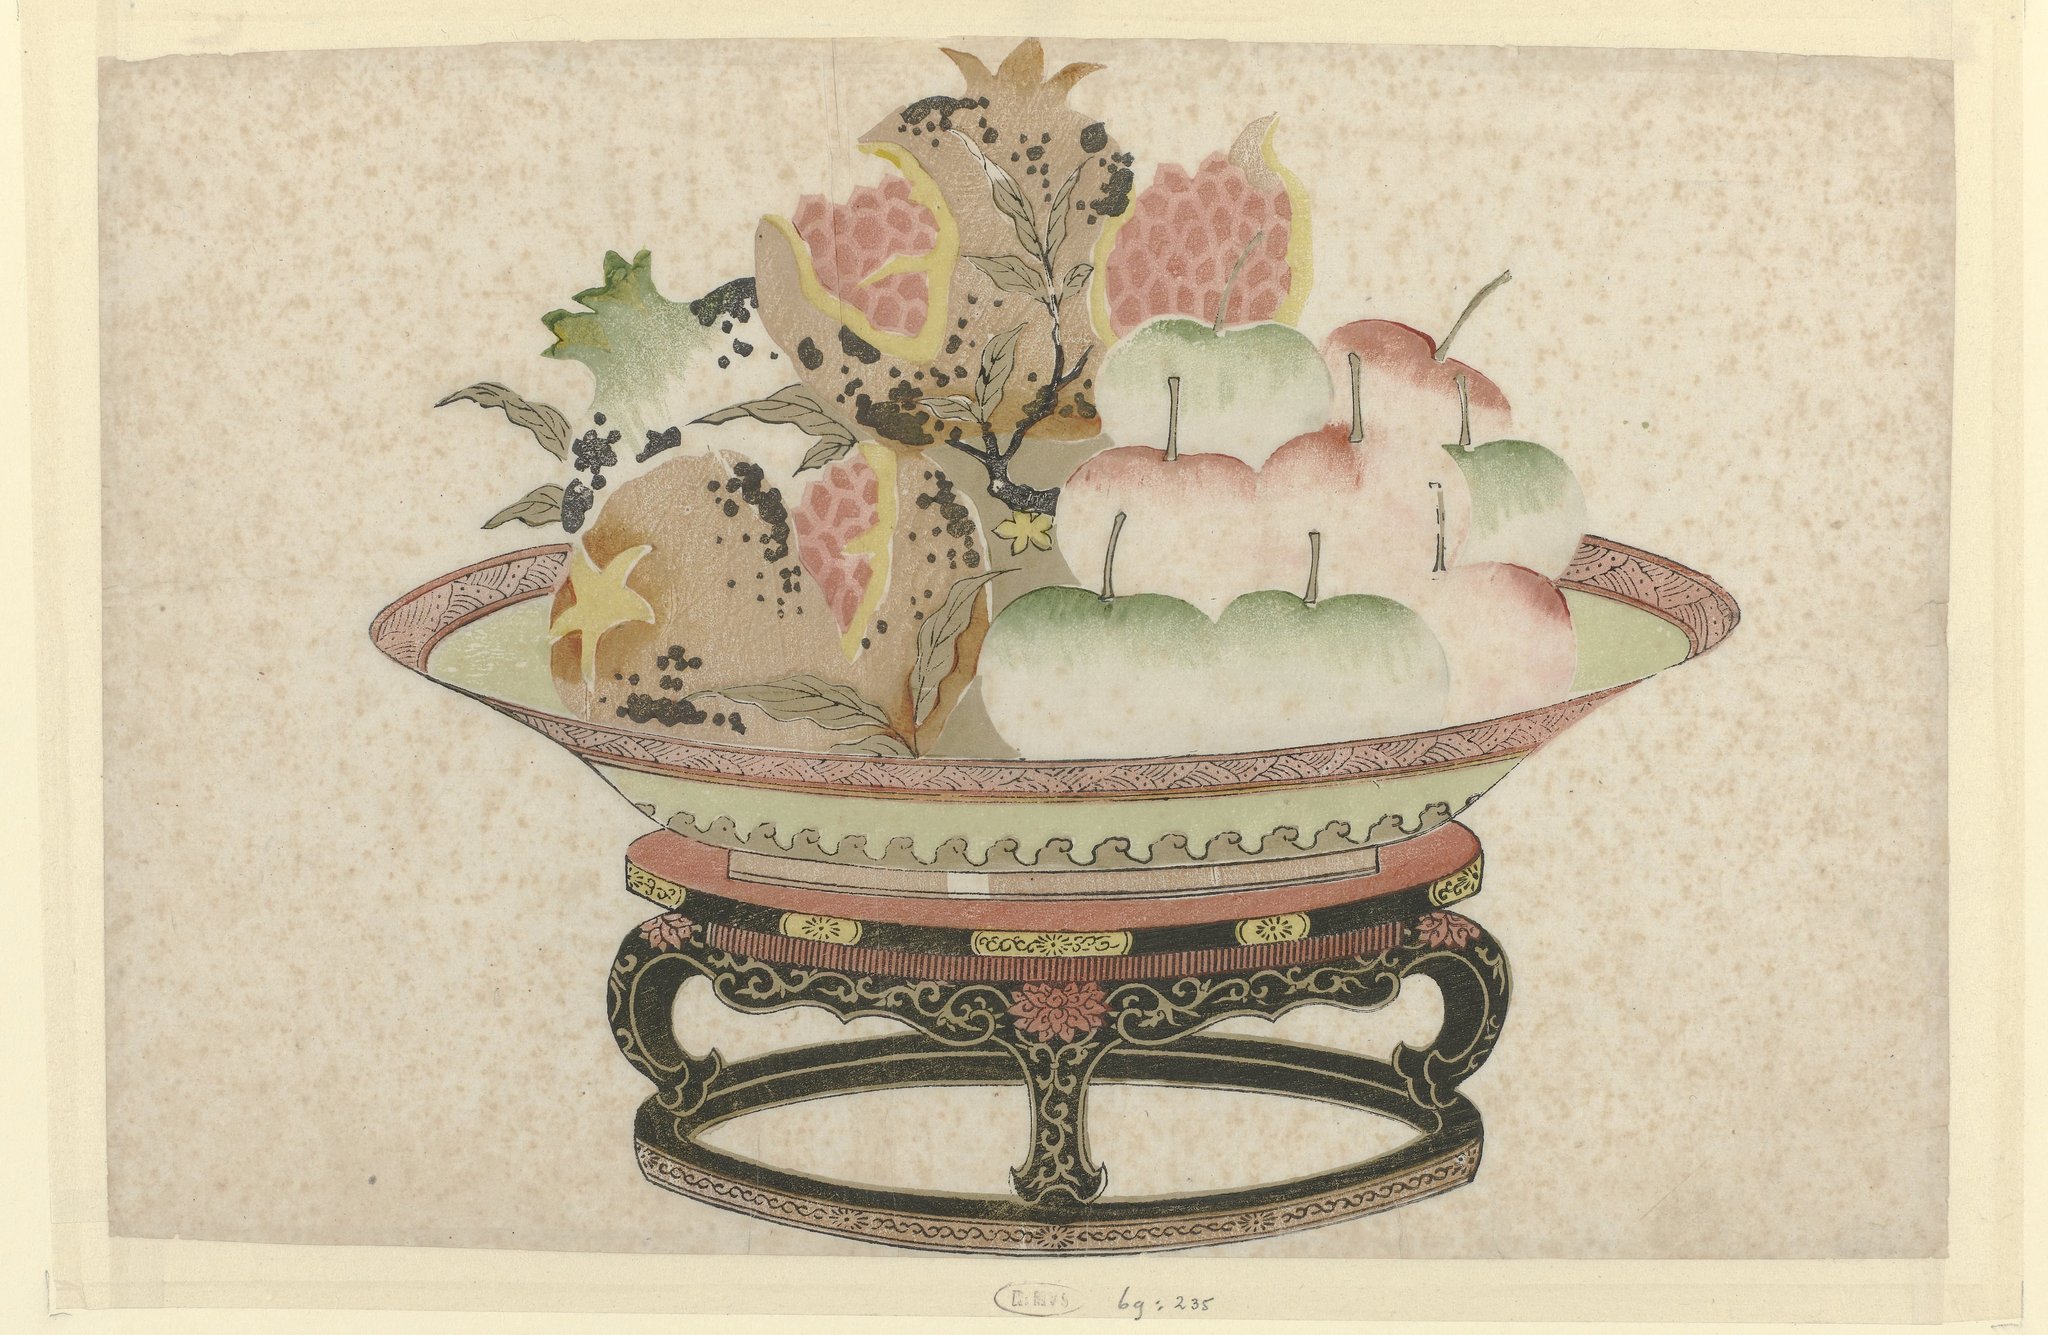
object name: print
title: Pomegranates and Apples in a Bowl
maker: Anonymous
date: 1600-1699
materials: paper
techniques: woodcut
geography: china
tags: fruit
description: This woodcut is specially meant for the Chinese New Year. The depicted objects are harbingers of good fortune. Because of its abundant seeds the pomegranate signifies prosperity. And the Chinese word for ‘apple’ sounds almost the same as the word for ‘peace’. If you give someone a few apples, you are basically saying ‘peace be with you!’